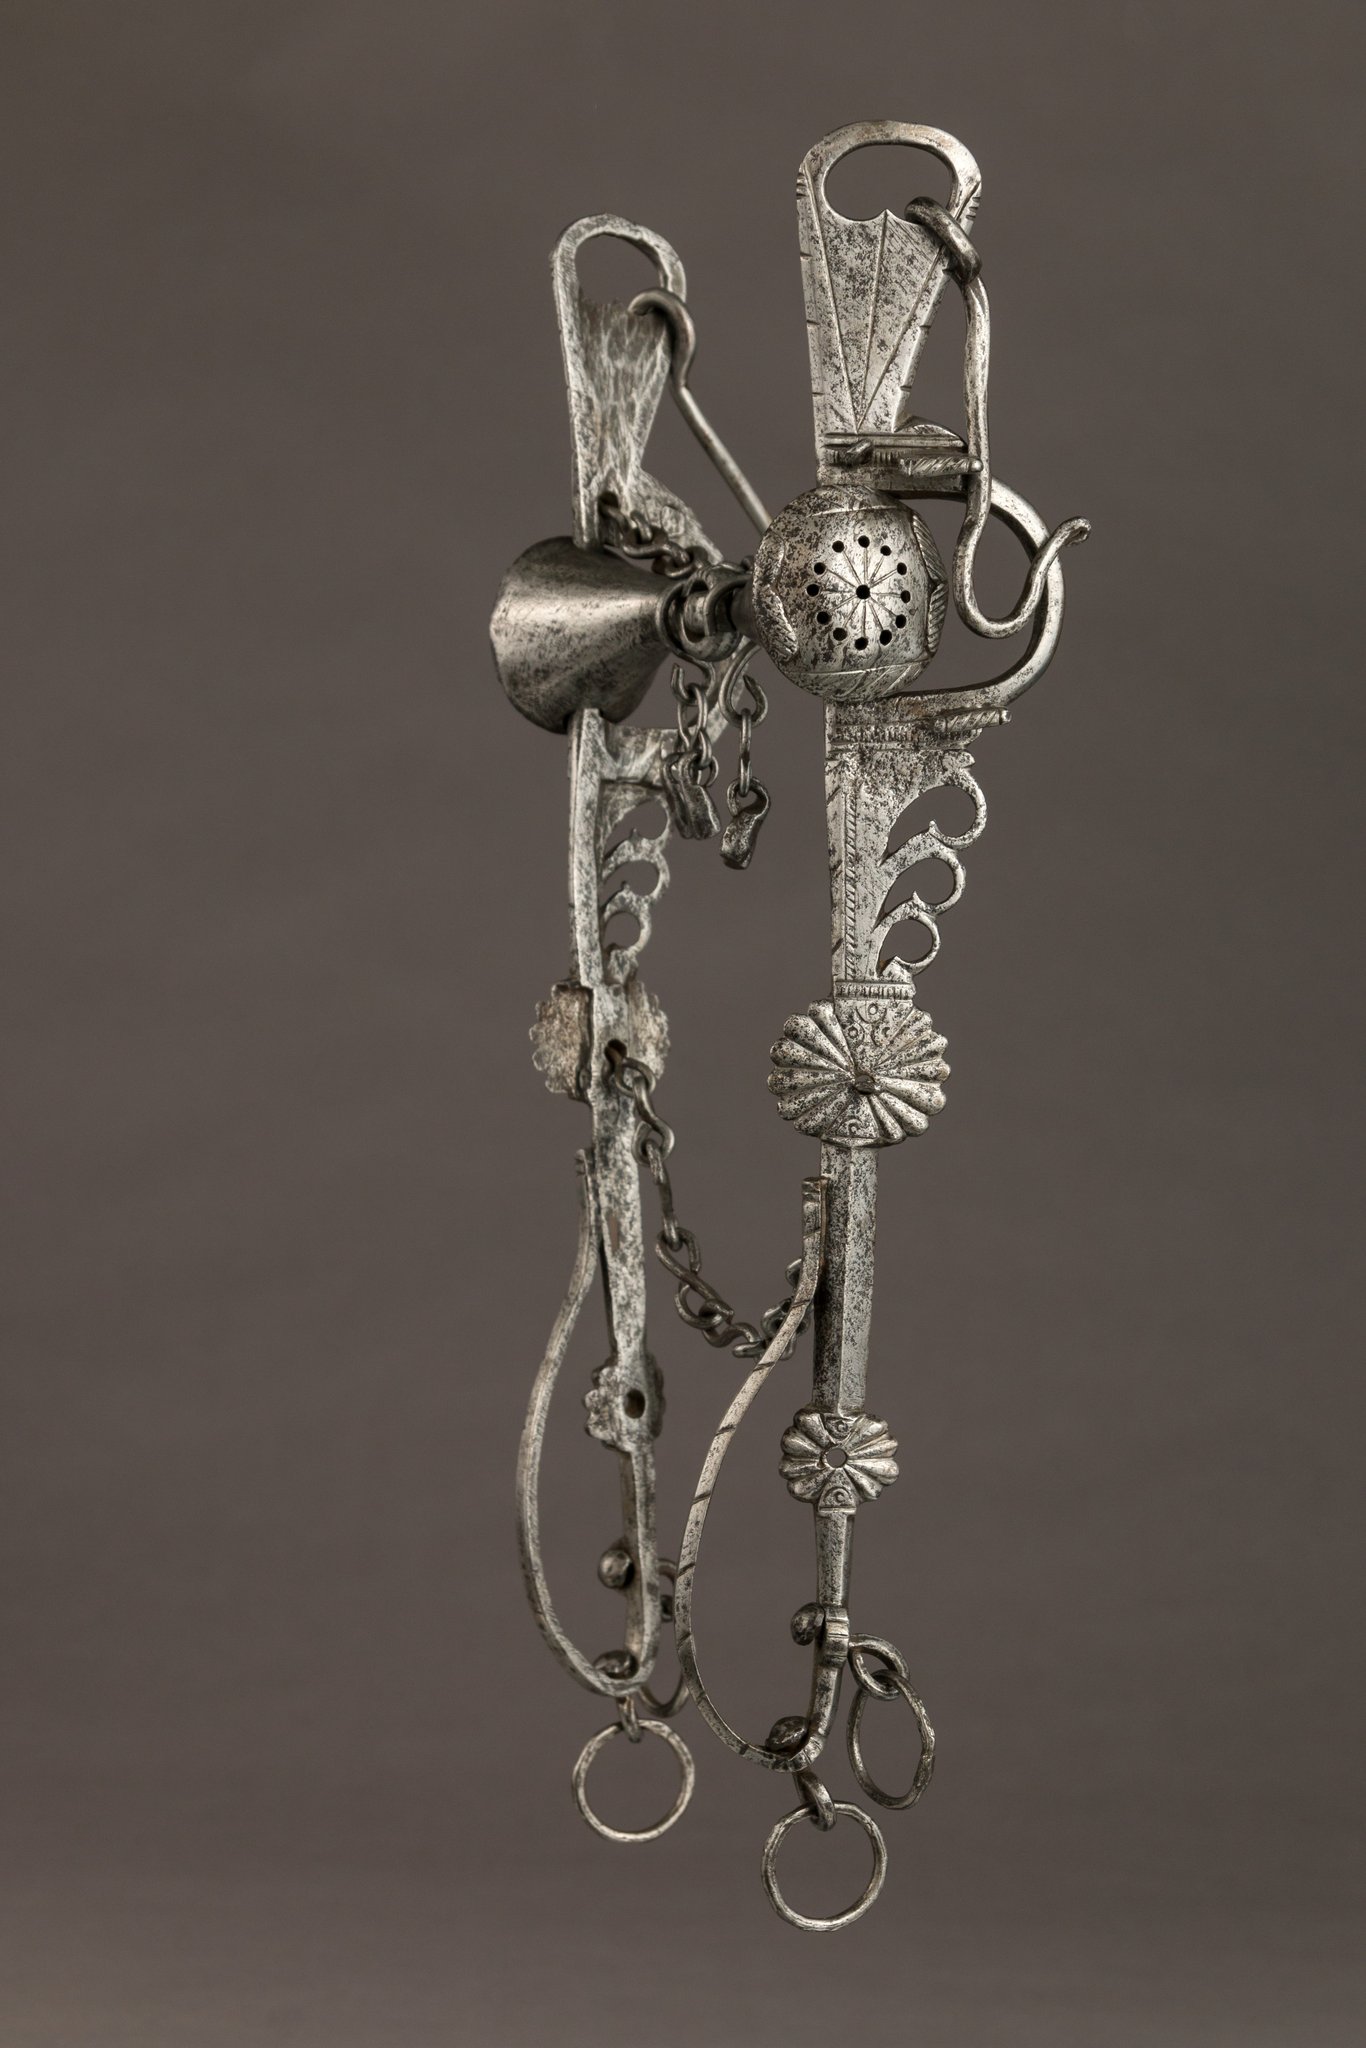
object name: bit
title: Curb Bit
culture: german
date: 1601-1633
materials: metal alloy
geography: germany